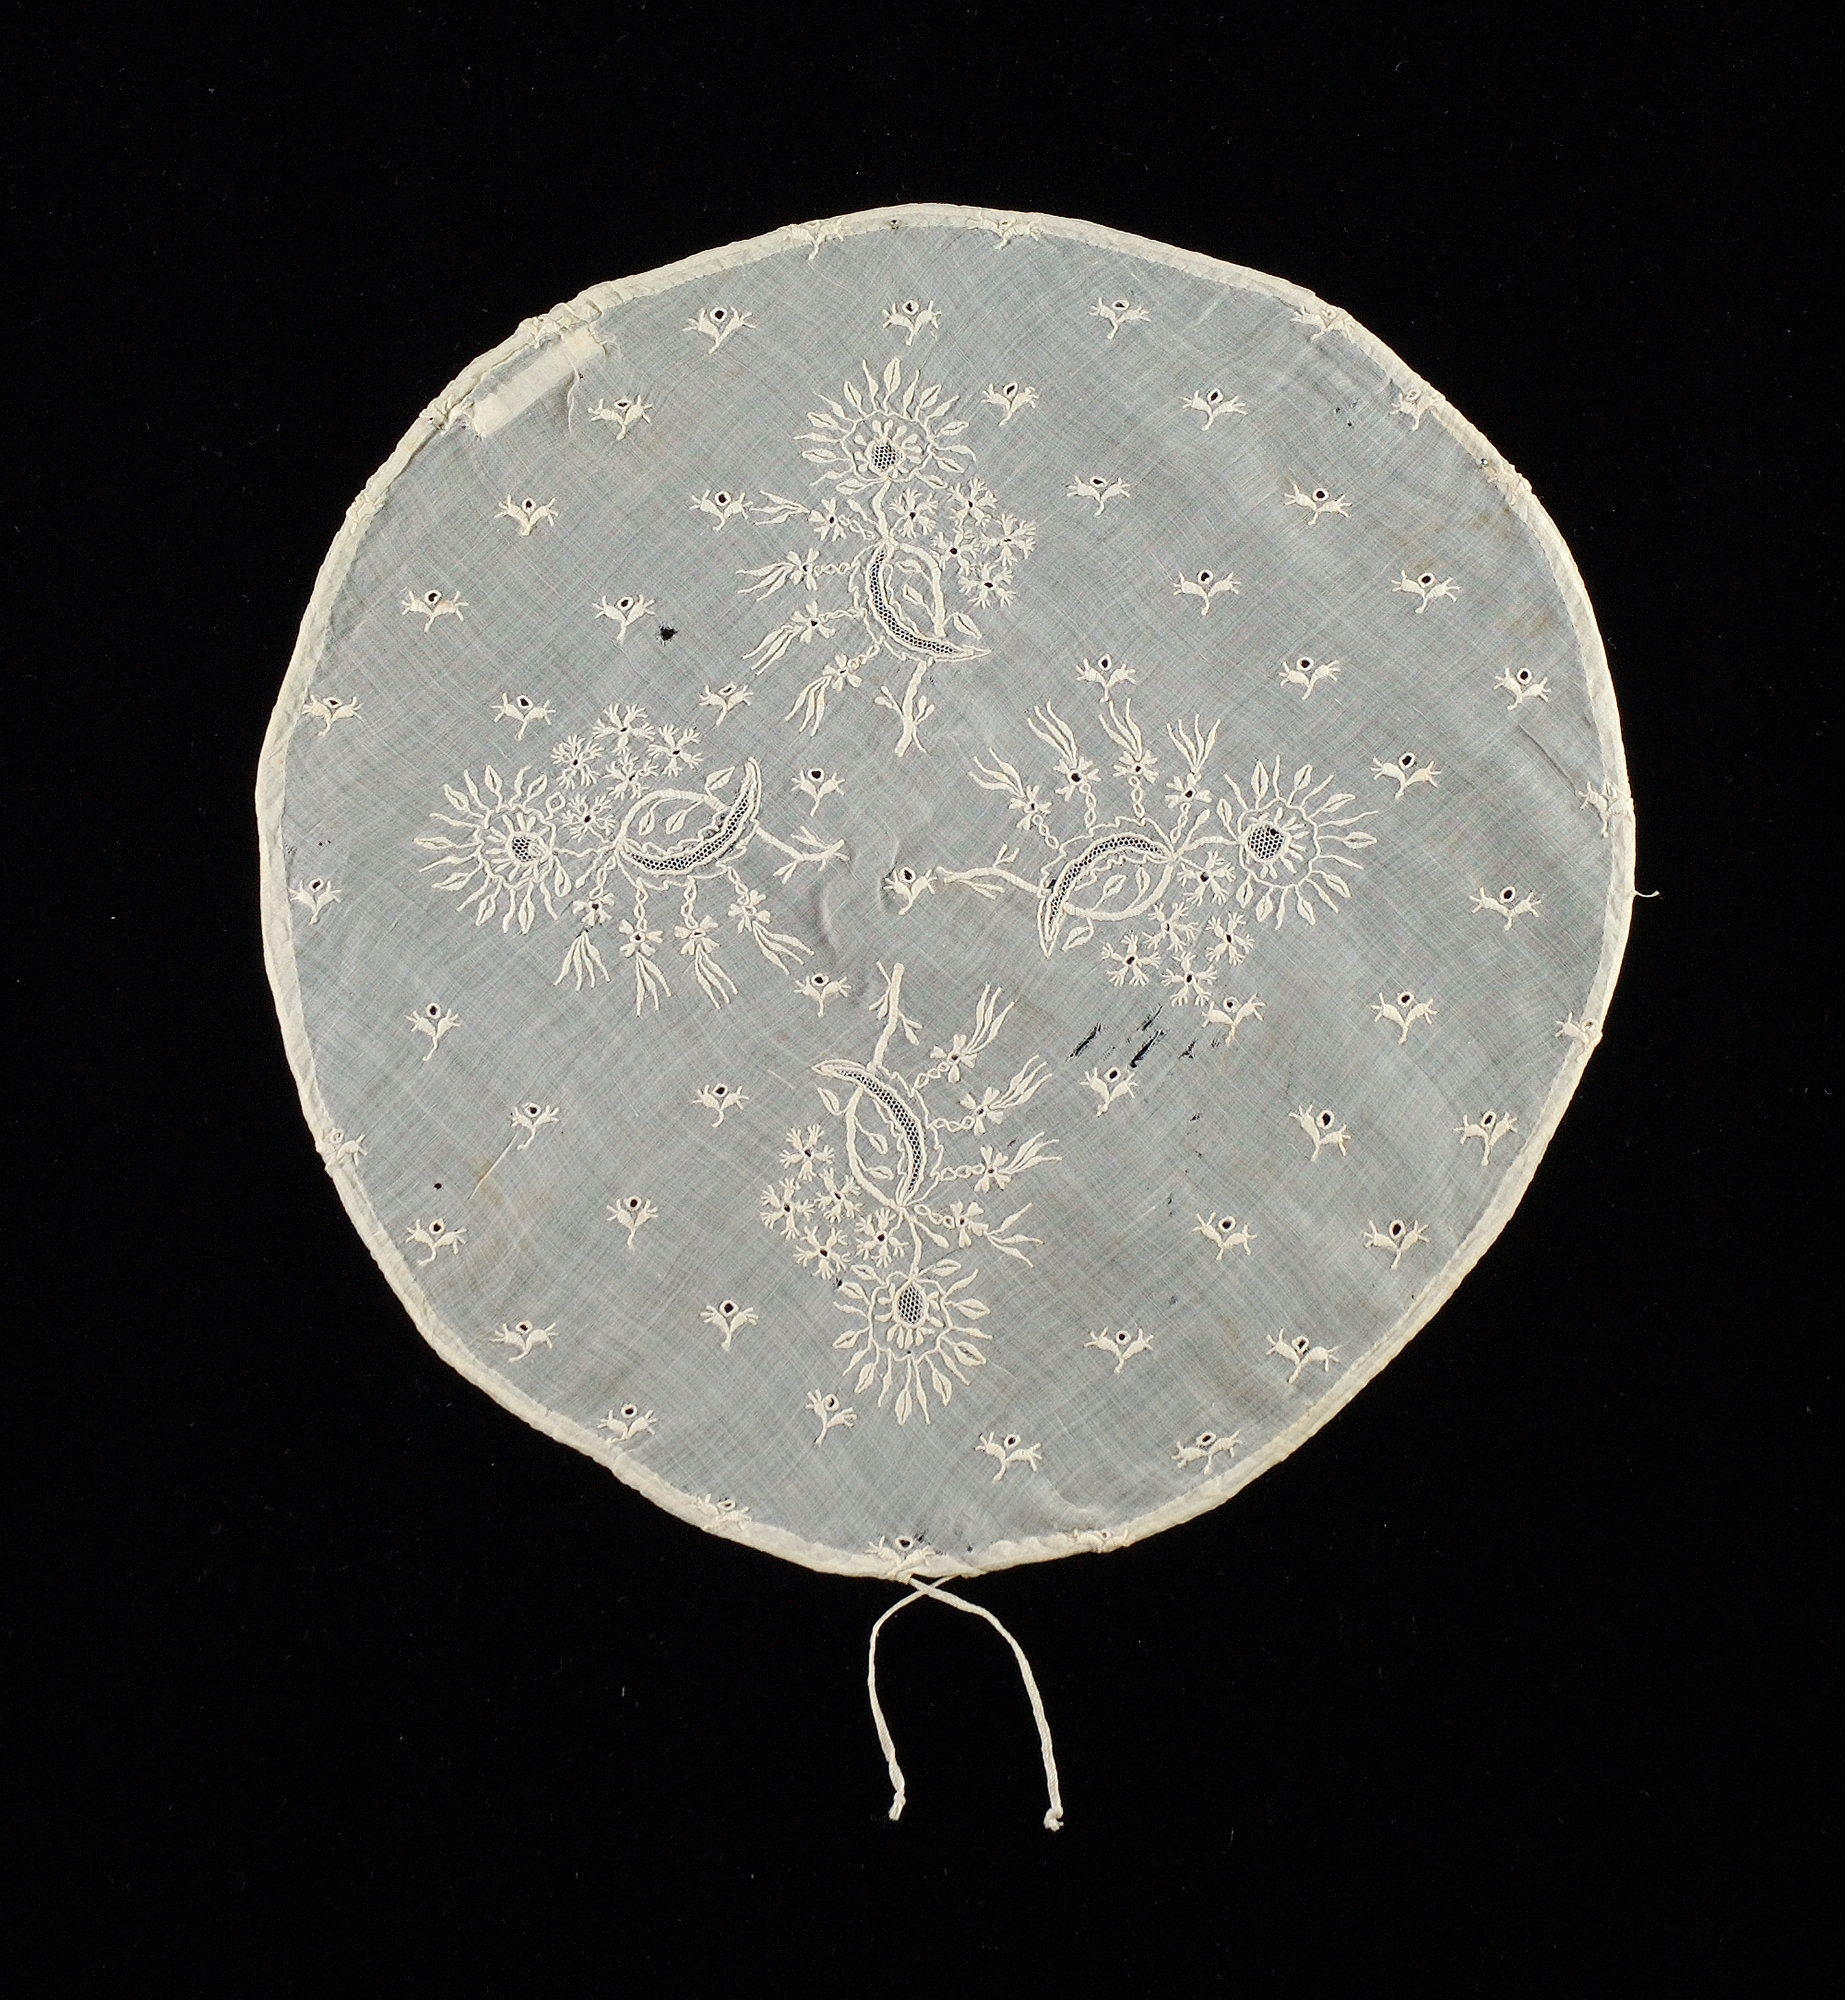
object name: cap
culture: french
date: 1875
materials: cotton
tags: flowers